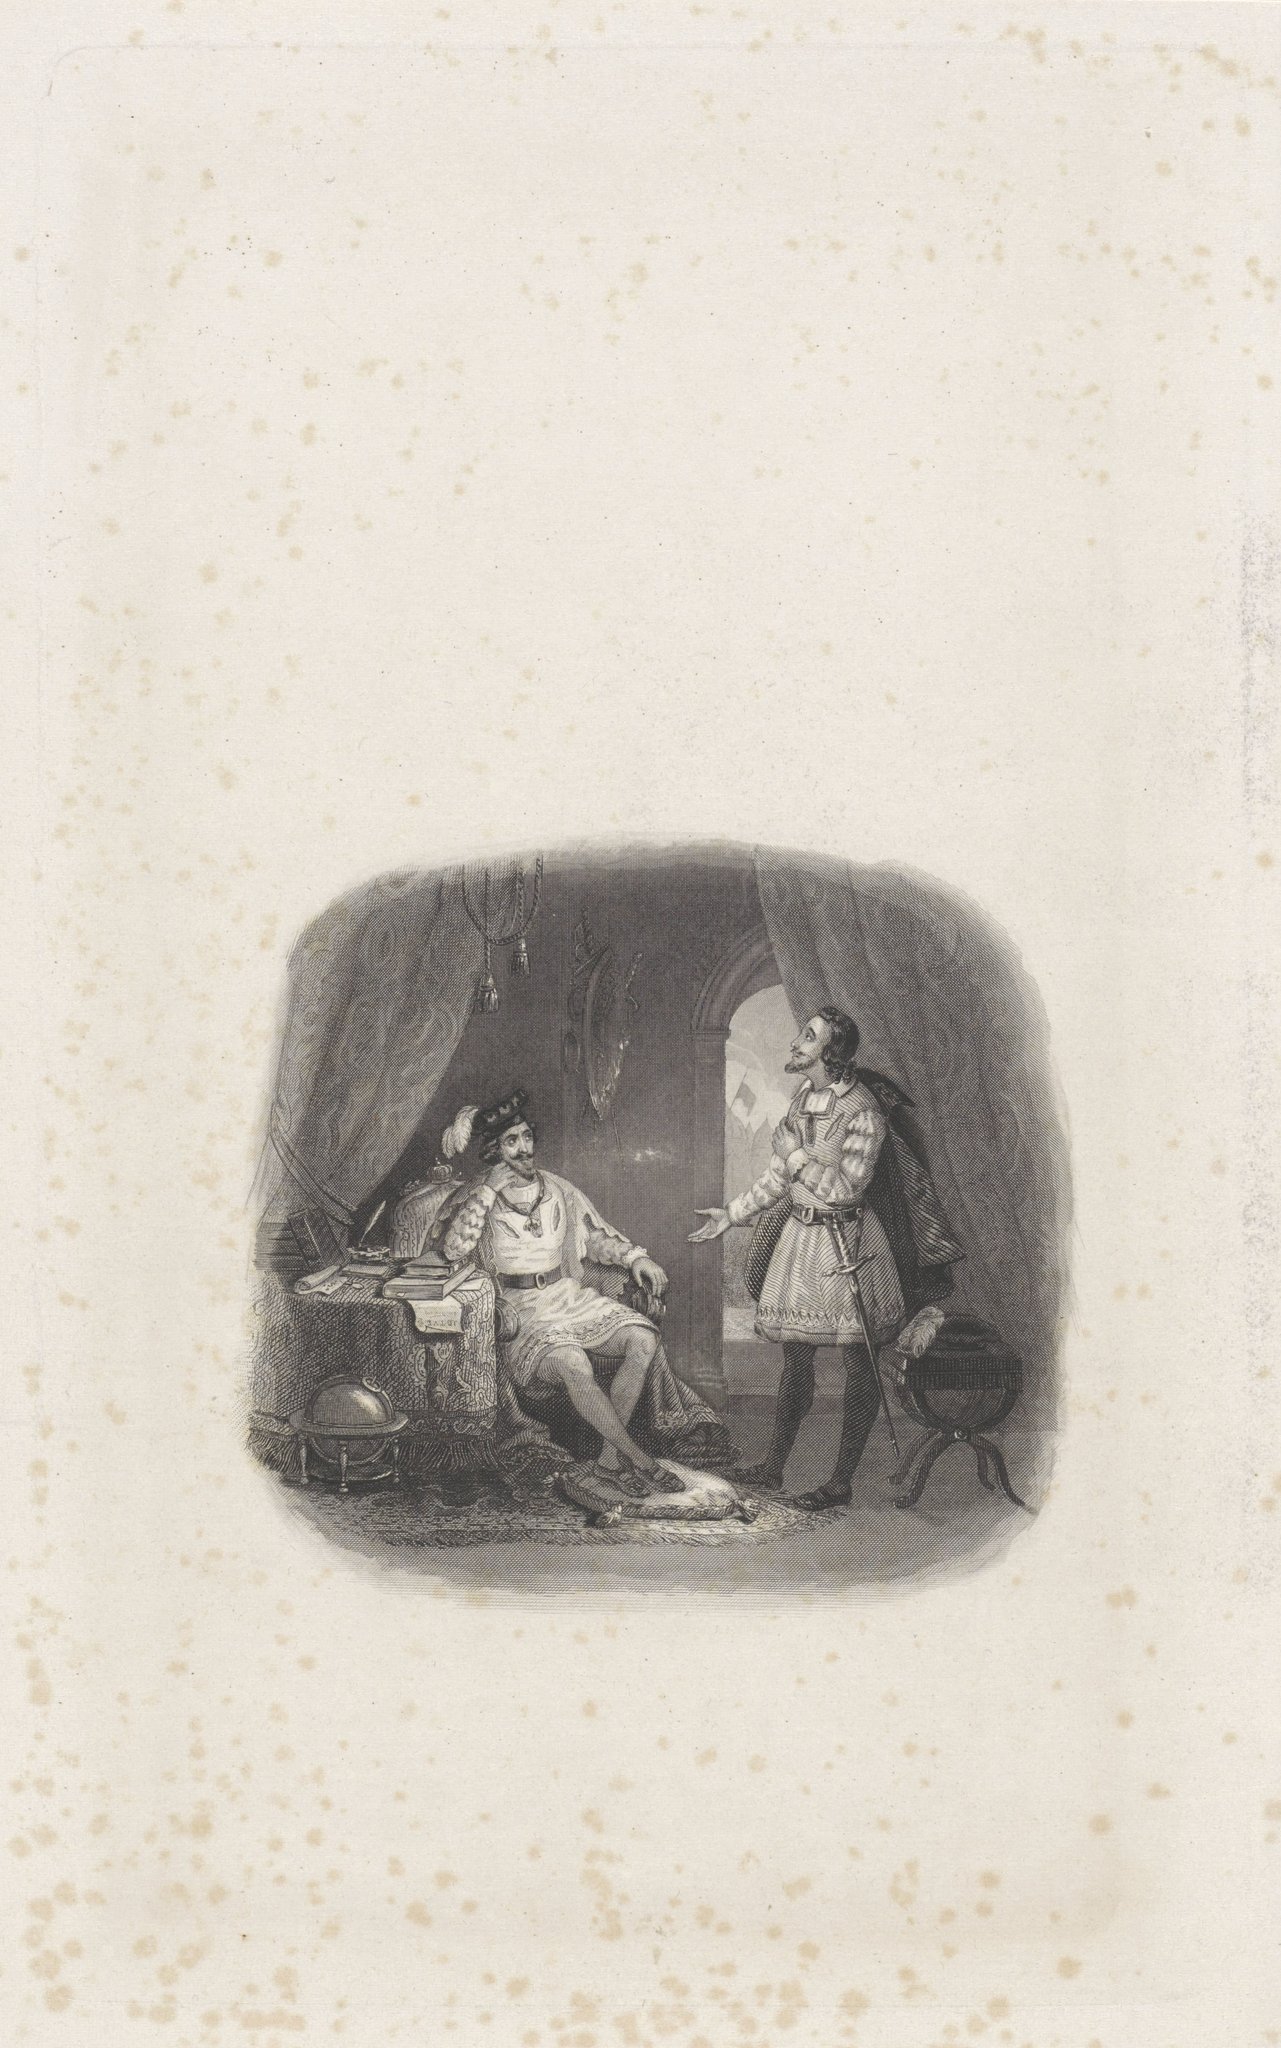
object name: print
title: Converserende edellieden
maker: dirk jurriaan sluyter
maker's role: draughtsman, print maker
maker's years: 1811-1886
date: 1826-1866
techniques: engraving, etching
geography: amsterdam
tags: book, conversation, dialogue; conversation piece, globe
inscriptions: collector's mark: Lugt 2228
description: Een edelman zit op een stoel bij een tafel met zijn voeten op een kussen. Op de tafel liggen boeken, oorkondes en schrijfgerei. Op de grond staat een globe. Een andere edelman praat met hem. Door een deur zijn tenten en vlaggen te zien.